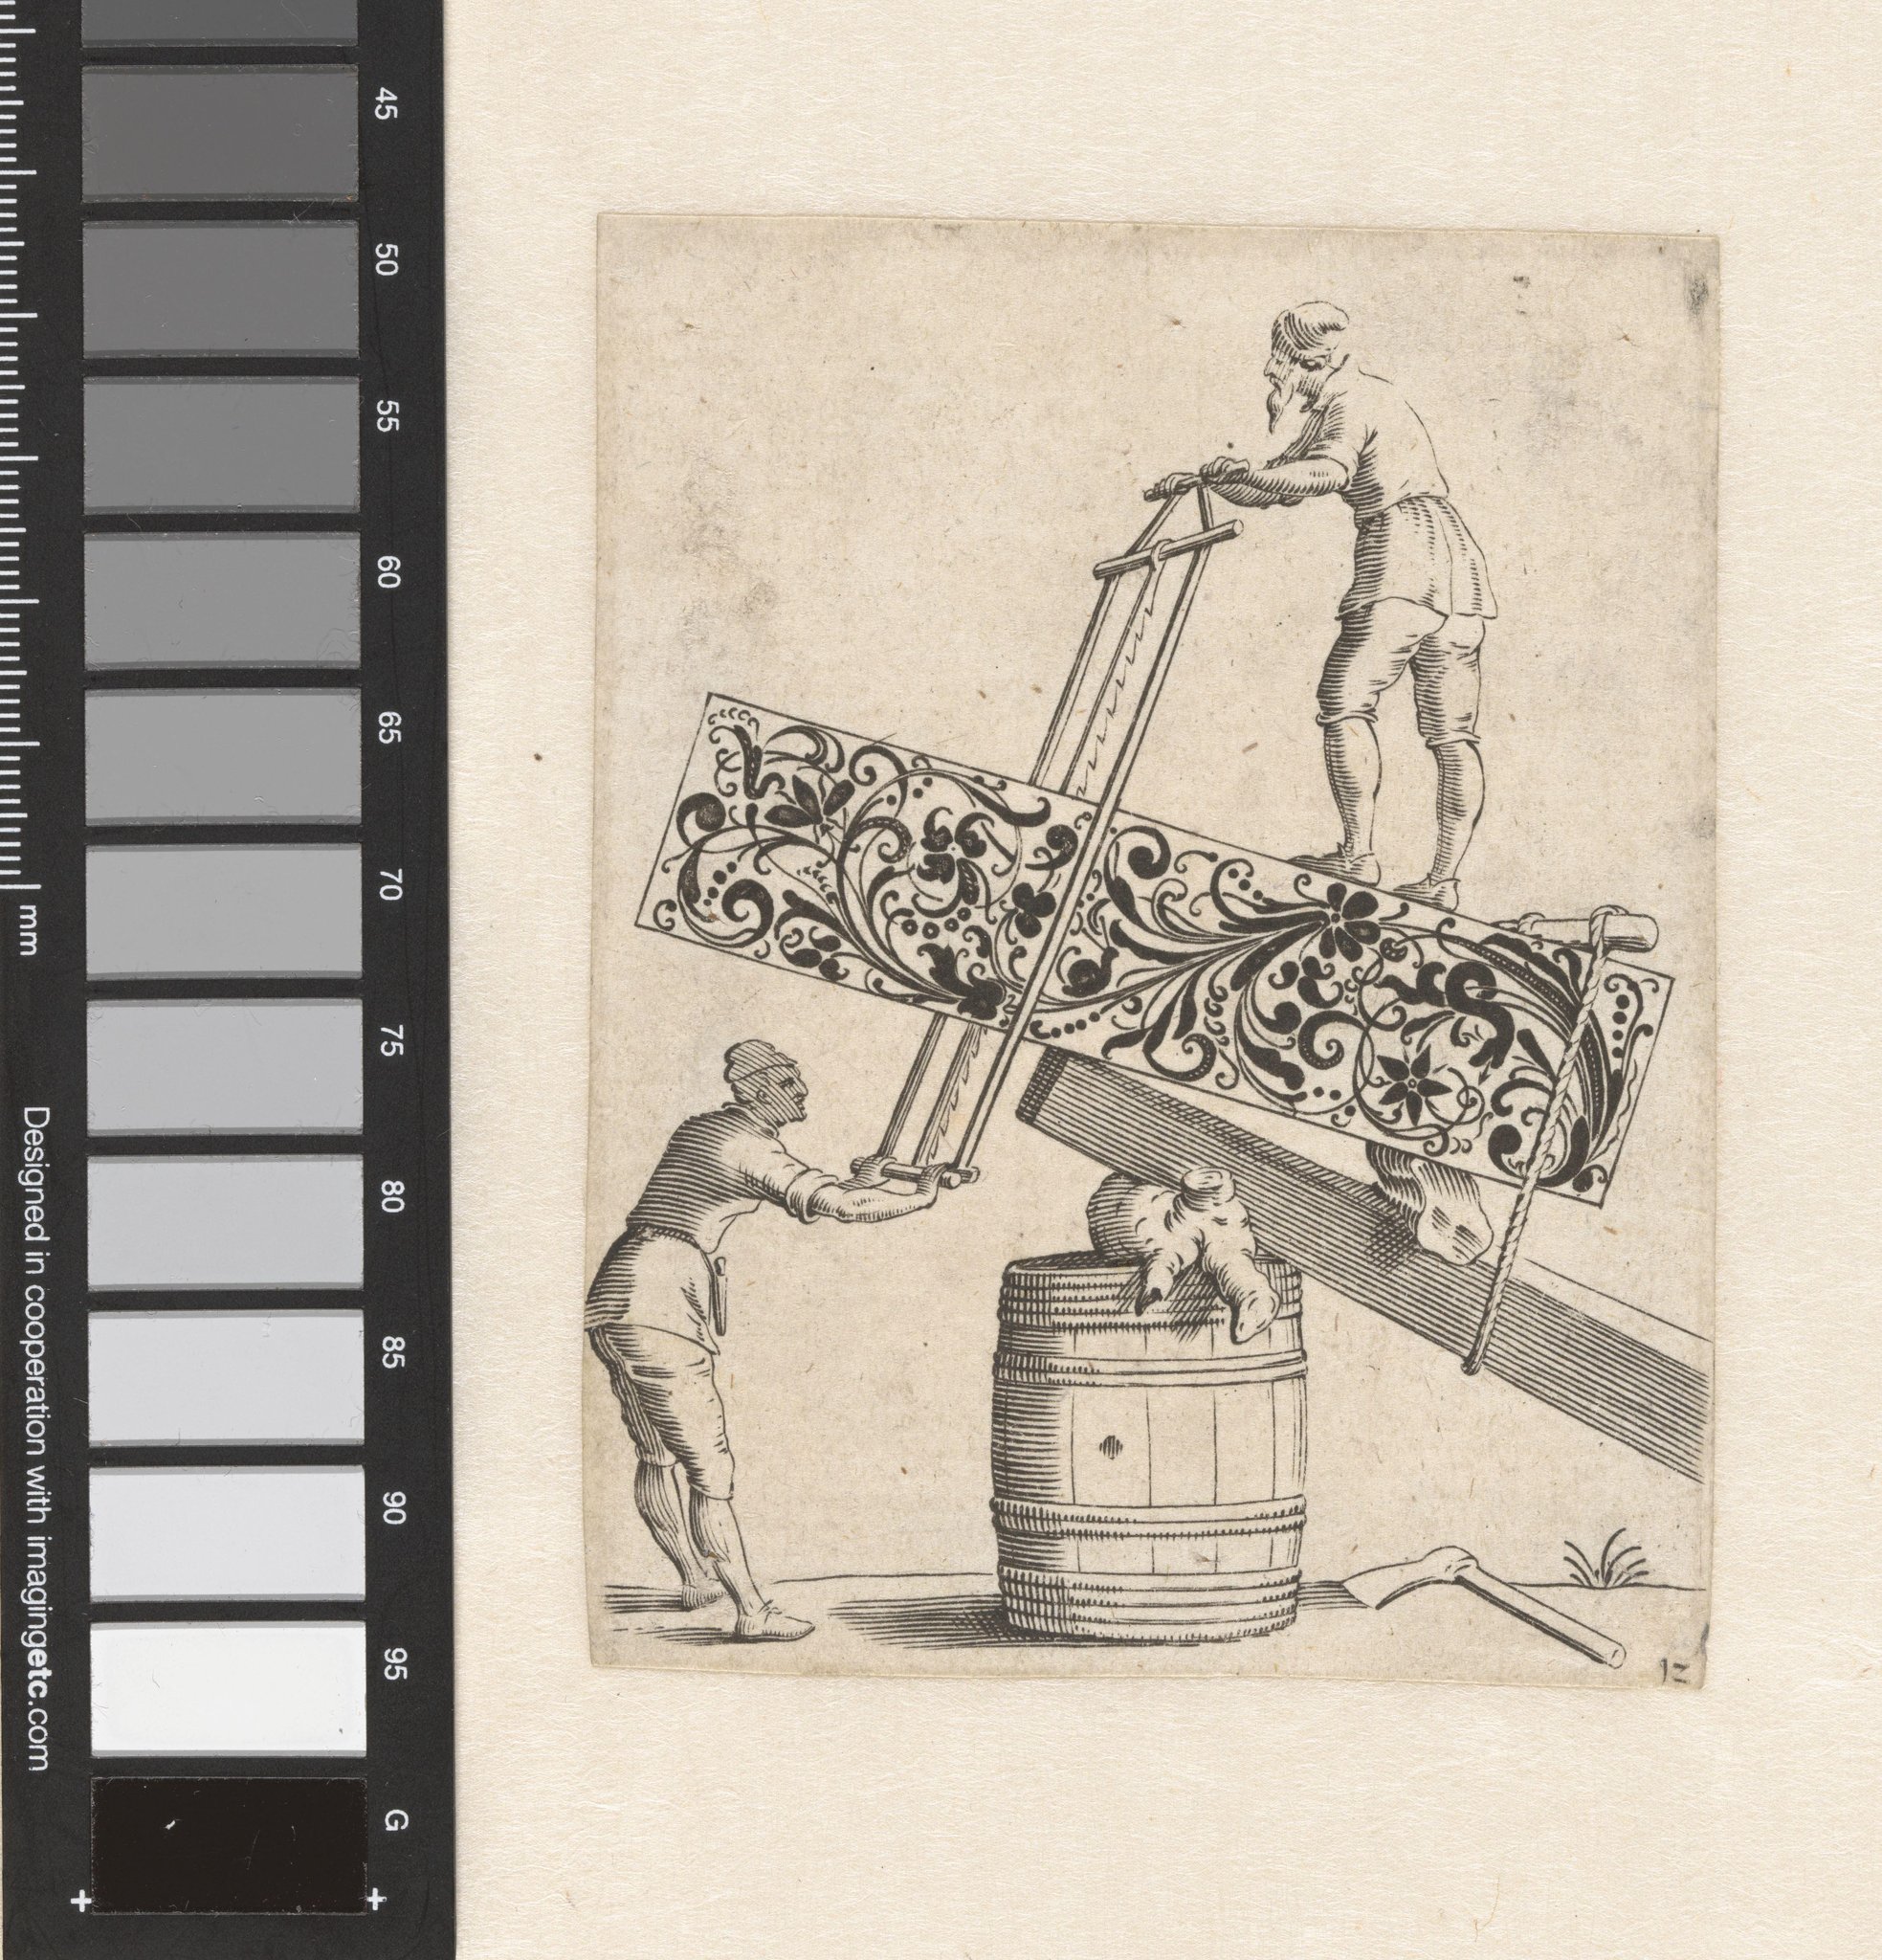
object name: print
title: Ontwerp voor heft van een zwaard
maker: jacob von der heijden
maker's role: print maker, publisher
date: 1619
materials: paper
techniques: engraving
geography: straatsburg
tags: ornaments ~ art, hacking and thrusting weapons: sword, tools, aids, implements ~ crafts and industries: saw, foliage, tendrils, branches ~ ornament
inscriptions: collector's mark, collector's mark: Lugt 2228, number: ‘12’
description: Gespiegelde kopie van een ontwerp voor een heft van een zwaard versierd met een gebladerte van bladeren en bloemen. Het ontwerp wordt gepresenteerd als een houten balk die wordt gezaagd door twee mannen.